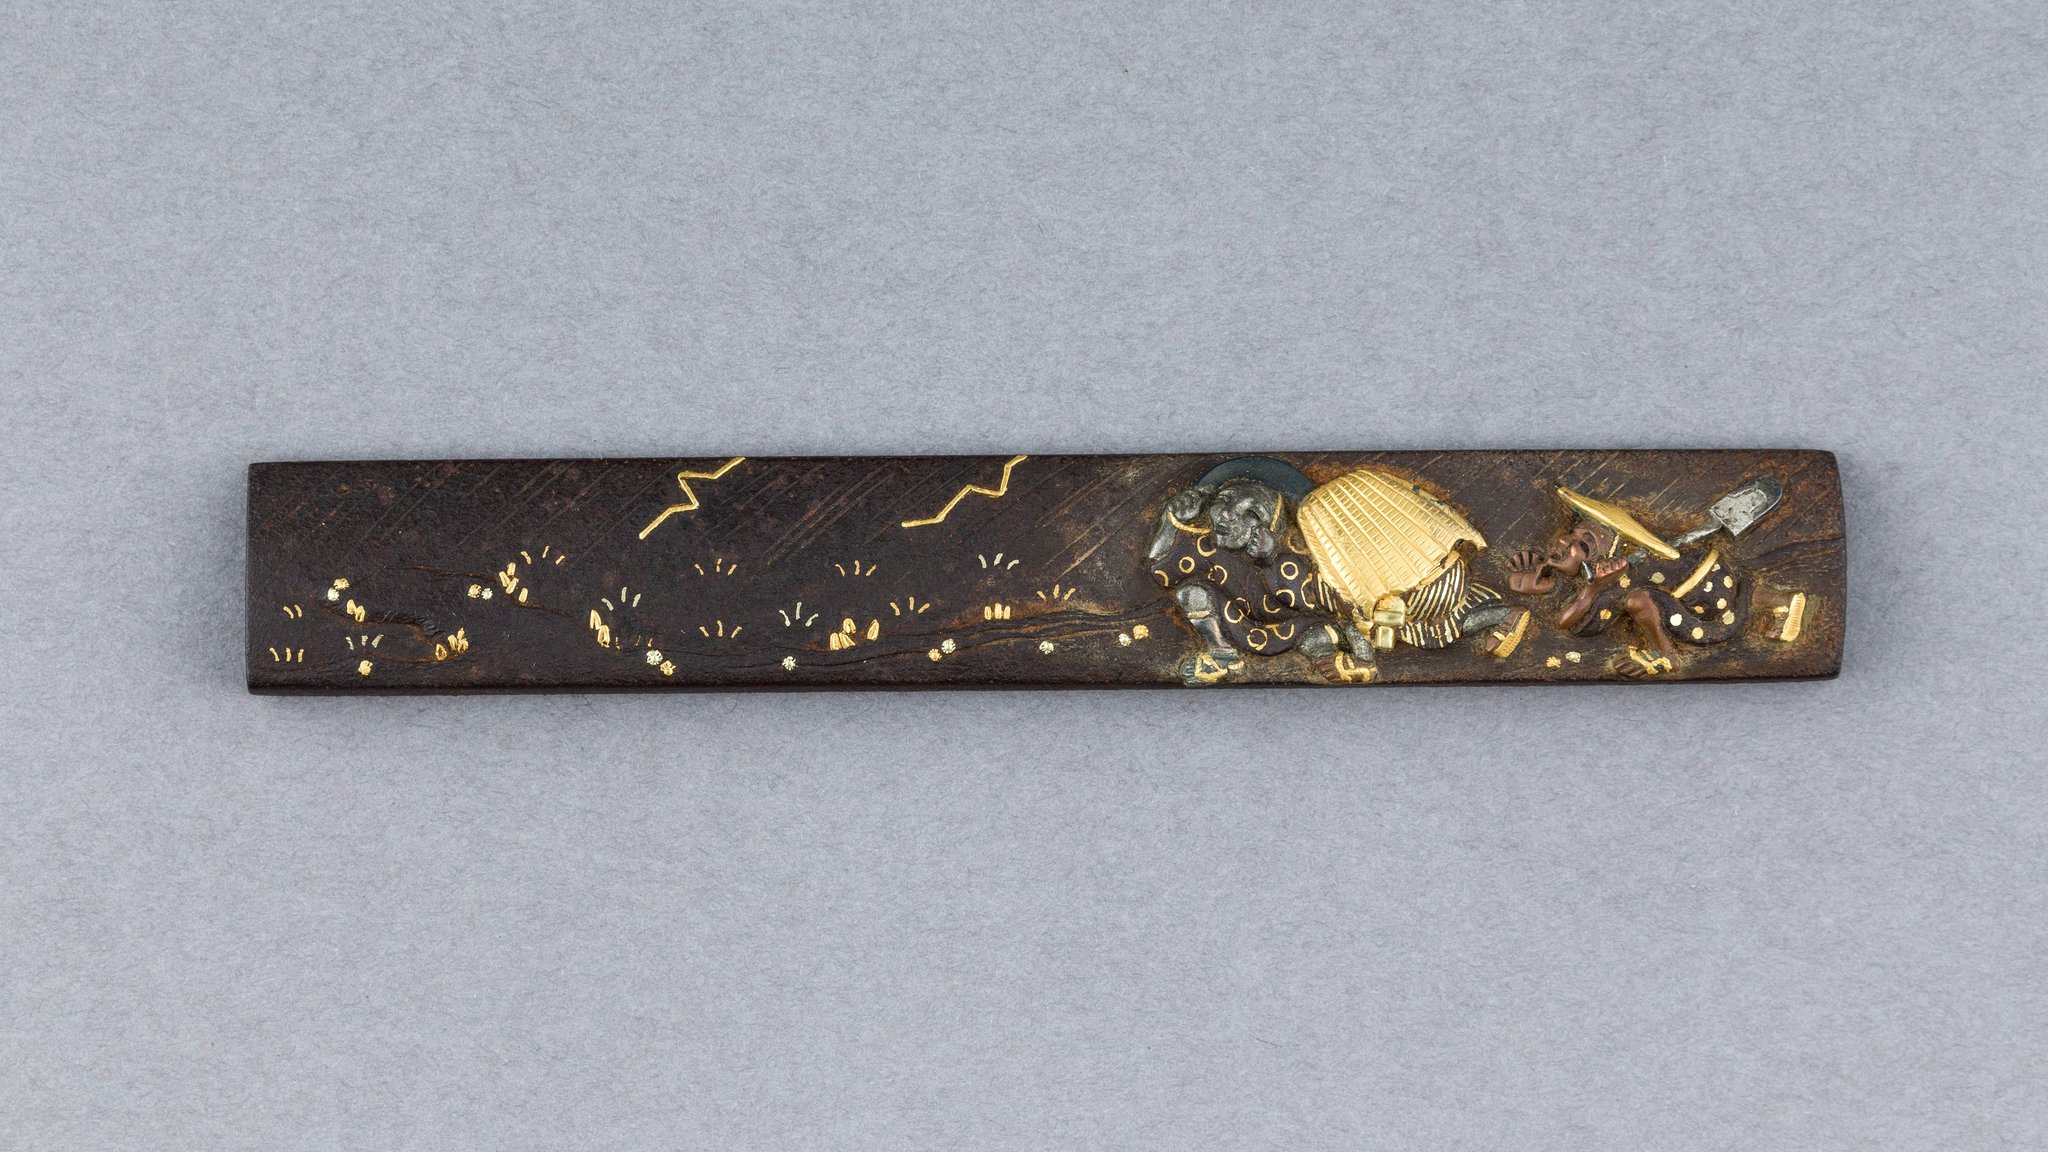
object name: knife handle kozuka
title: Knife Handle (Kozuka)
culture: japanese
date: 1615-1868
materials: copper, gold, iron, silver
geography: japan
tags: human figures